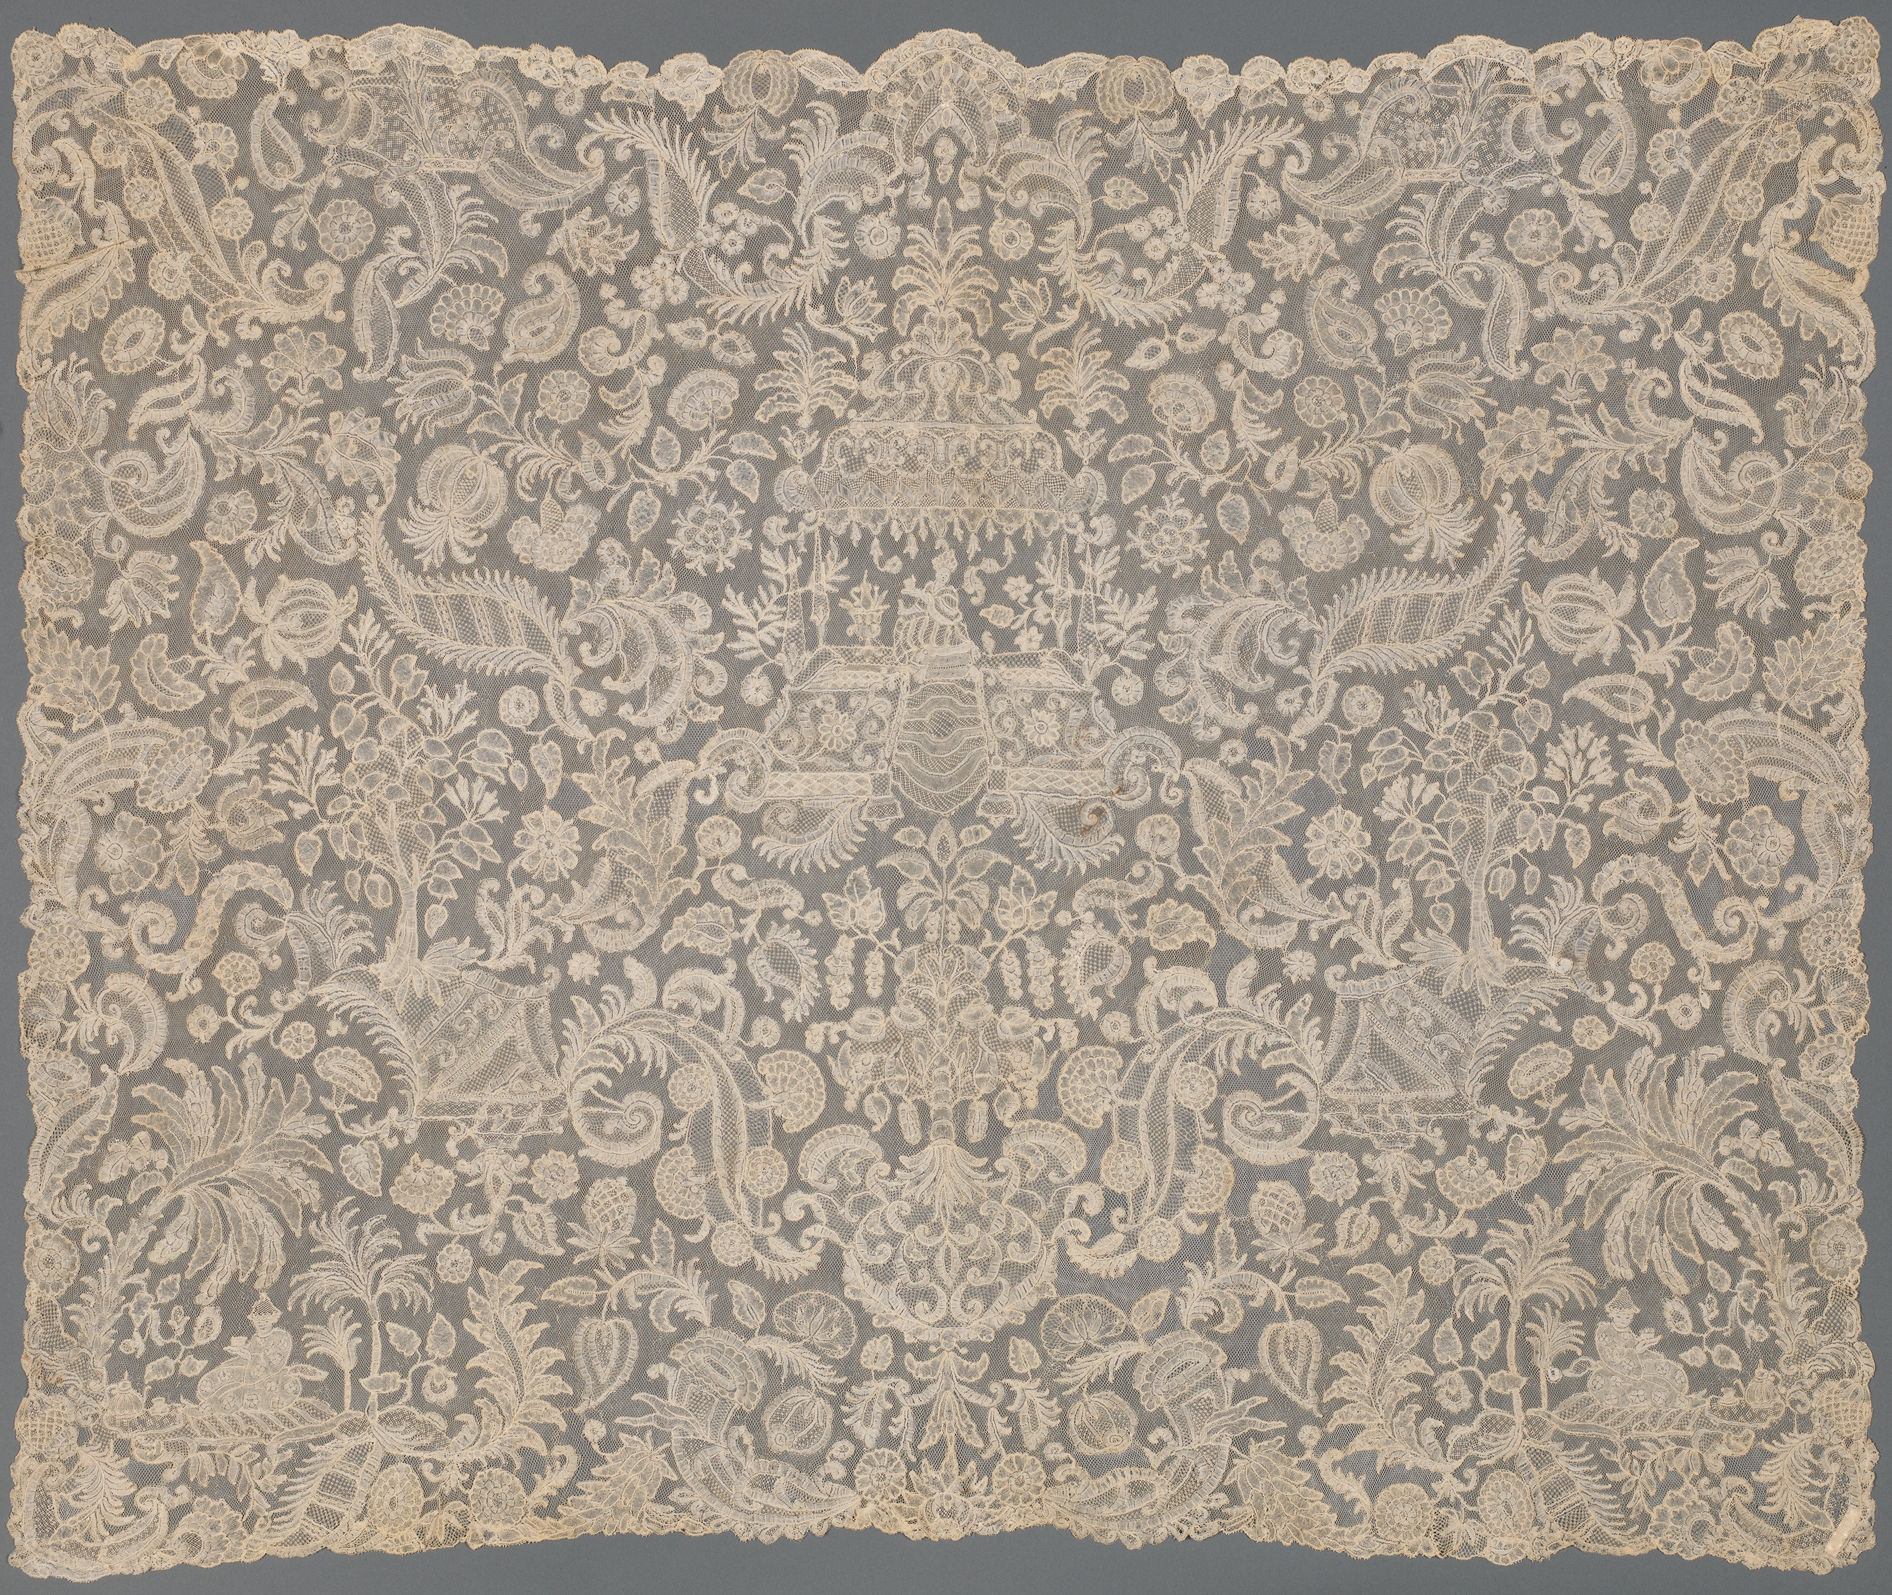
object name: cover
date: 1730-1750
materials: linen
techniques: lace